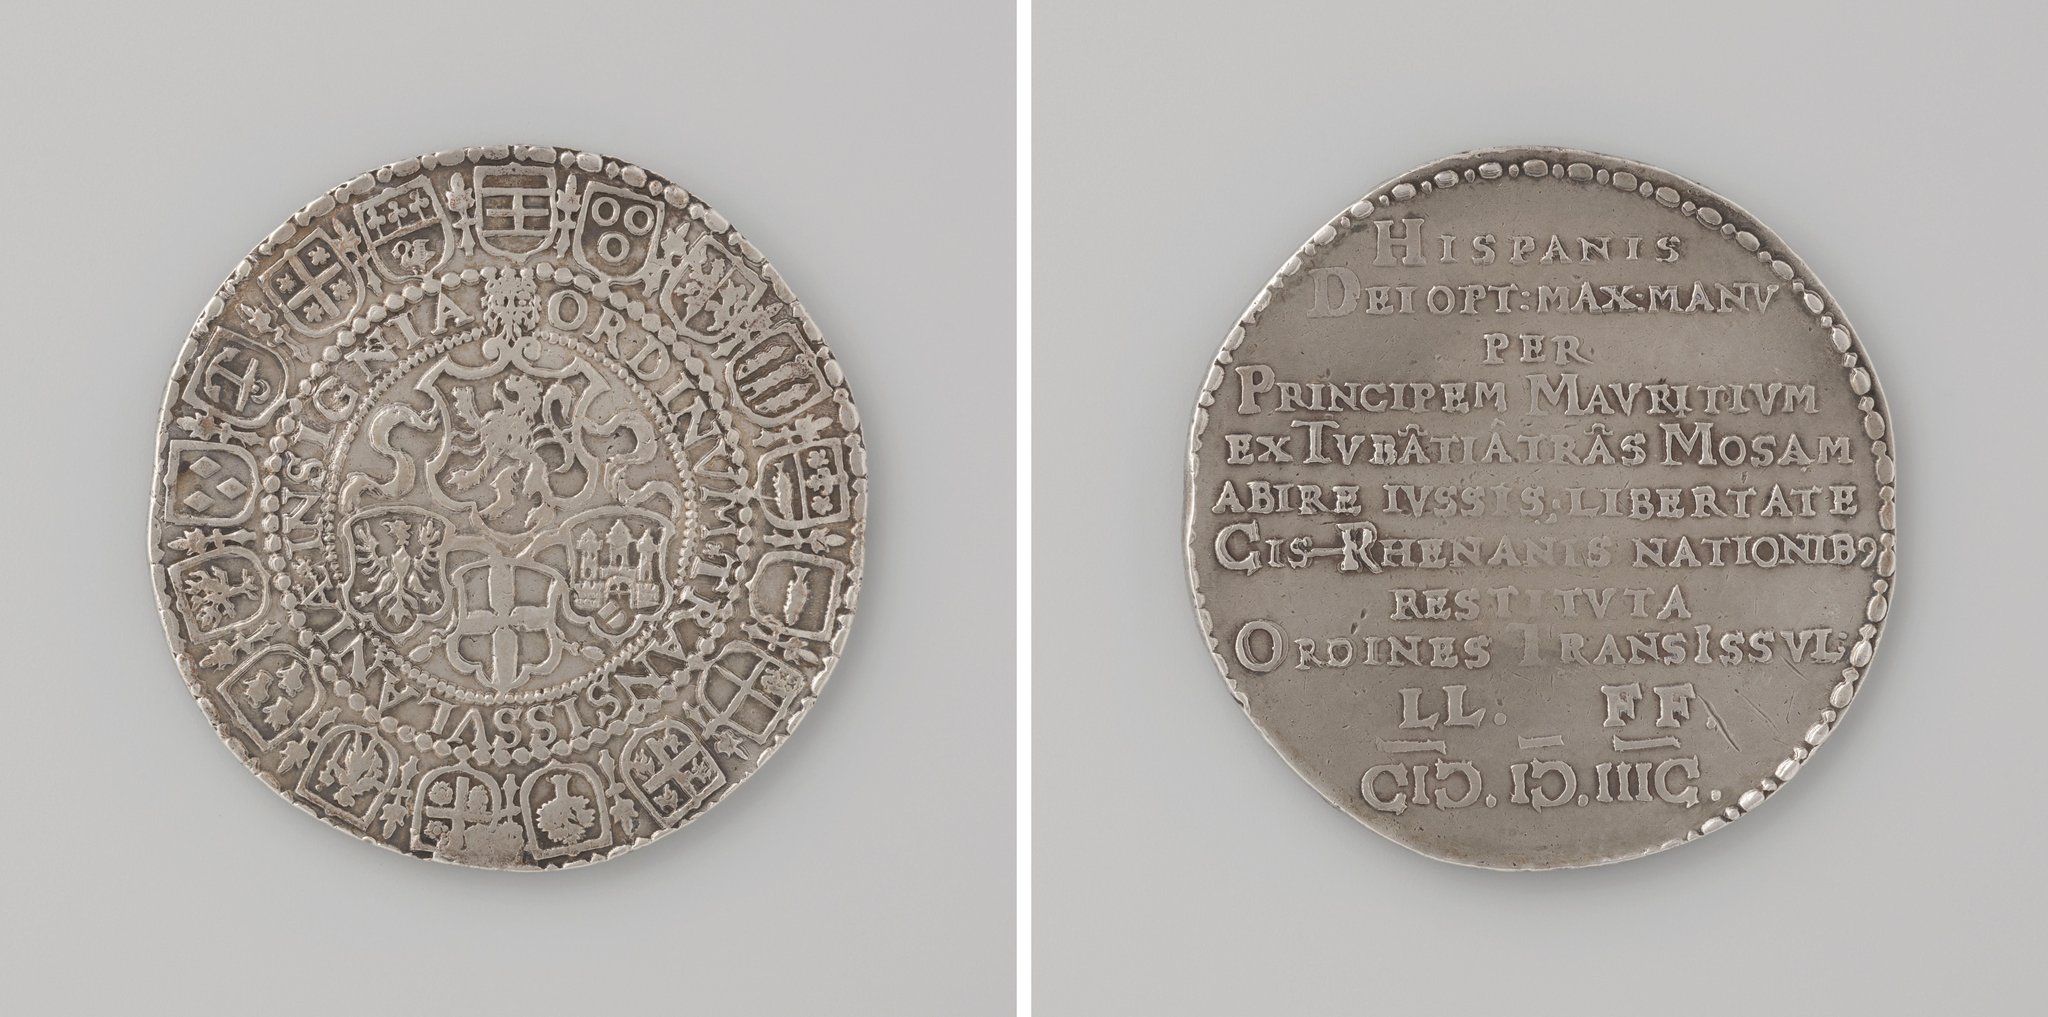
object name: history medal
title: Bevrijding van Twente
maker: Anonymous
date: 1597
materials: silver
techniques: striking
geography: overijssel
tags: staten van overijssel, turnhout, overijssel, rijnberg, groenlo, lingen, ootmarsum, enschede, bredevoort, alpen, meurs, oldenzaal, tachtigjarige oorlog, inname van negen steden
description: Zilveren penning. Voorzijde: centraal vier wapenschilden (Overijssel, Deventer, Zwolle, Kampen); langs buitenrand: zeventien wapenschilden (Staten van Overijssel). Keerzijde: opschrift, buitenrand gedeeltelijk aanwezig (scheef geslagen)